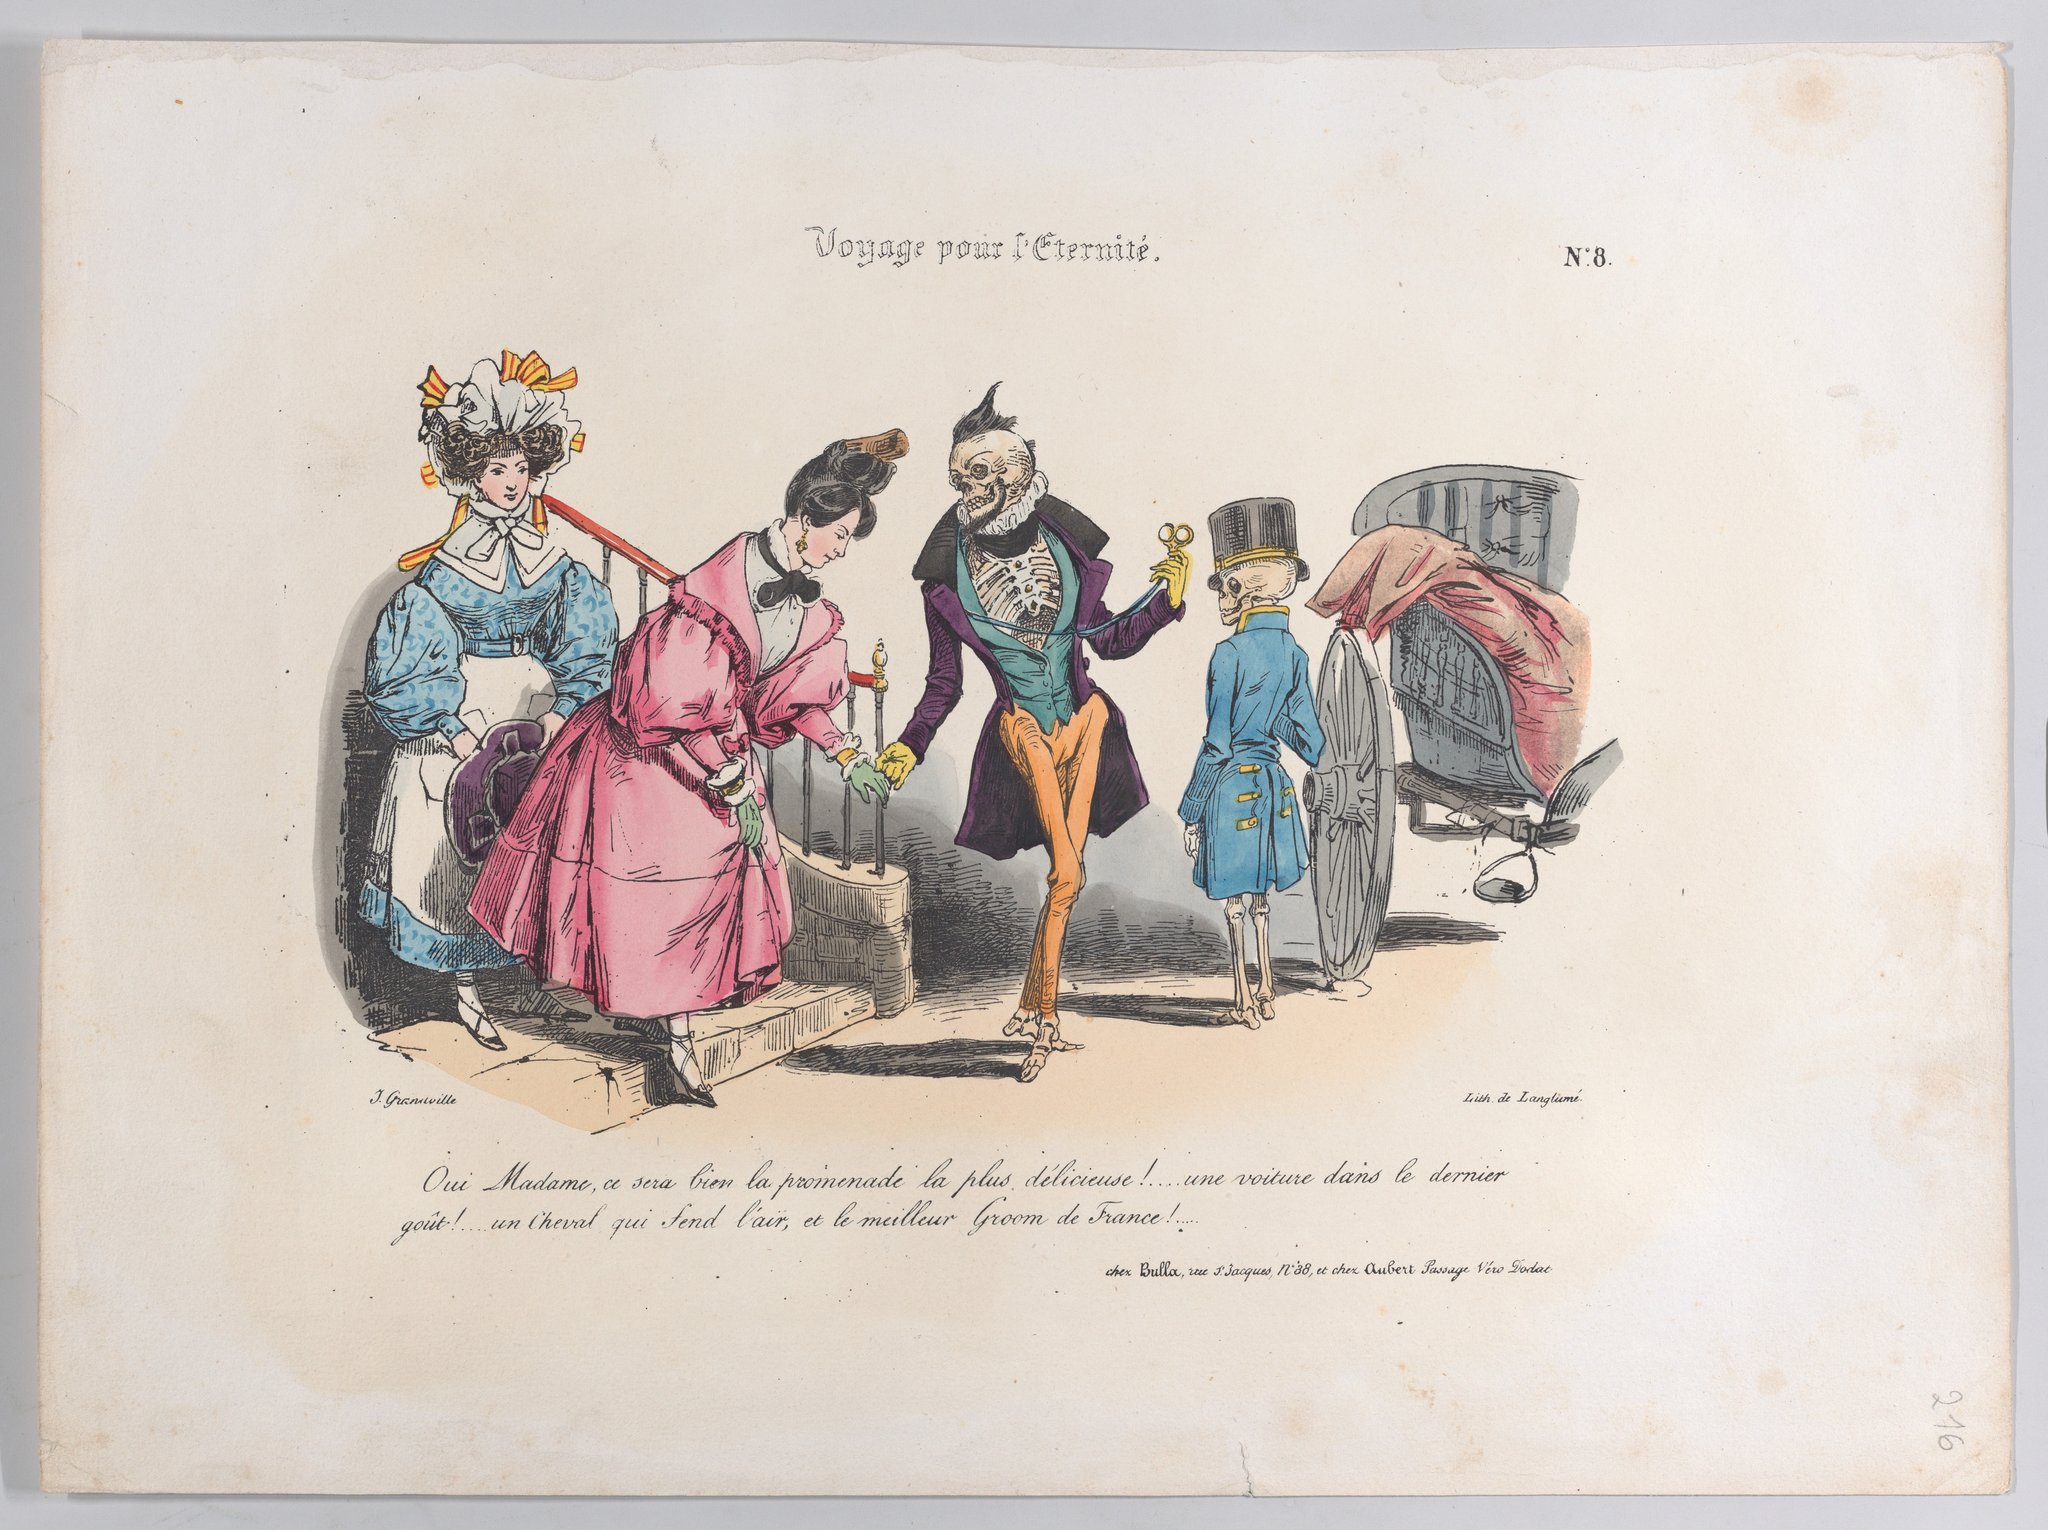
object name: print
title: Journey for Eternity, No. 1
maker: j. j. grandville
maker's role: designer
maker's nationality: french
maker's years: 1803-1847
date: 1839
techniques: lithograph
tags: skeletons,women